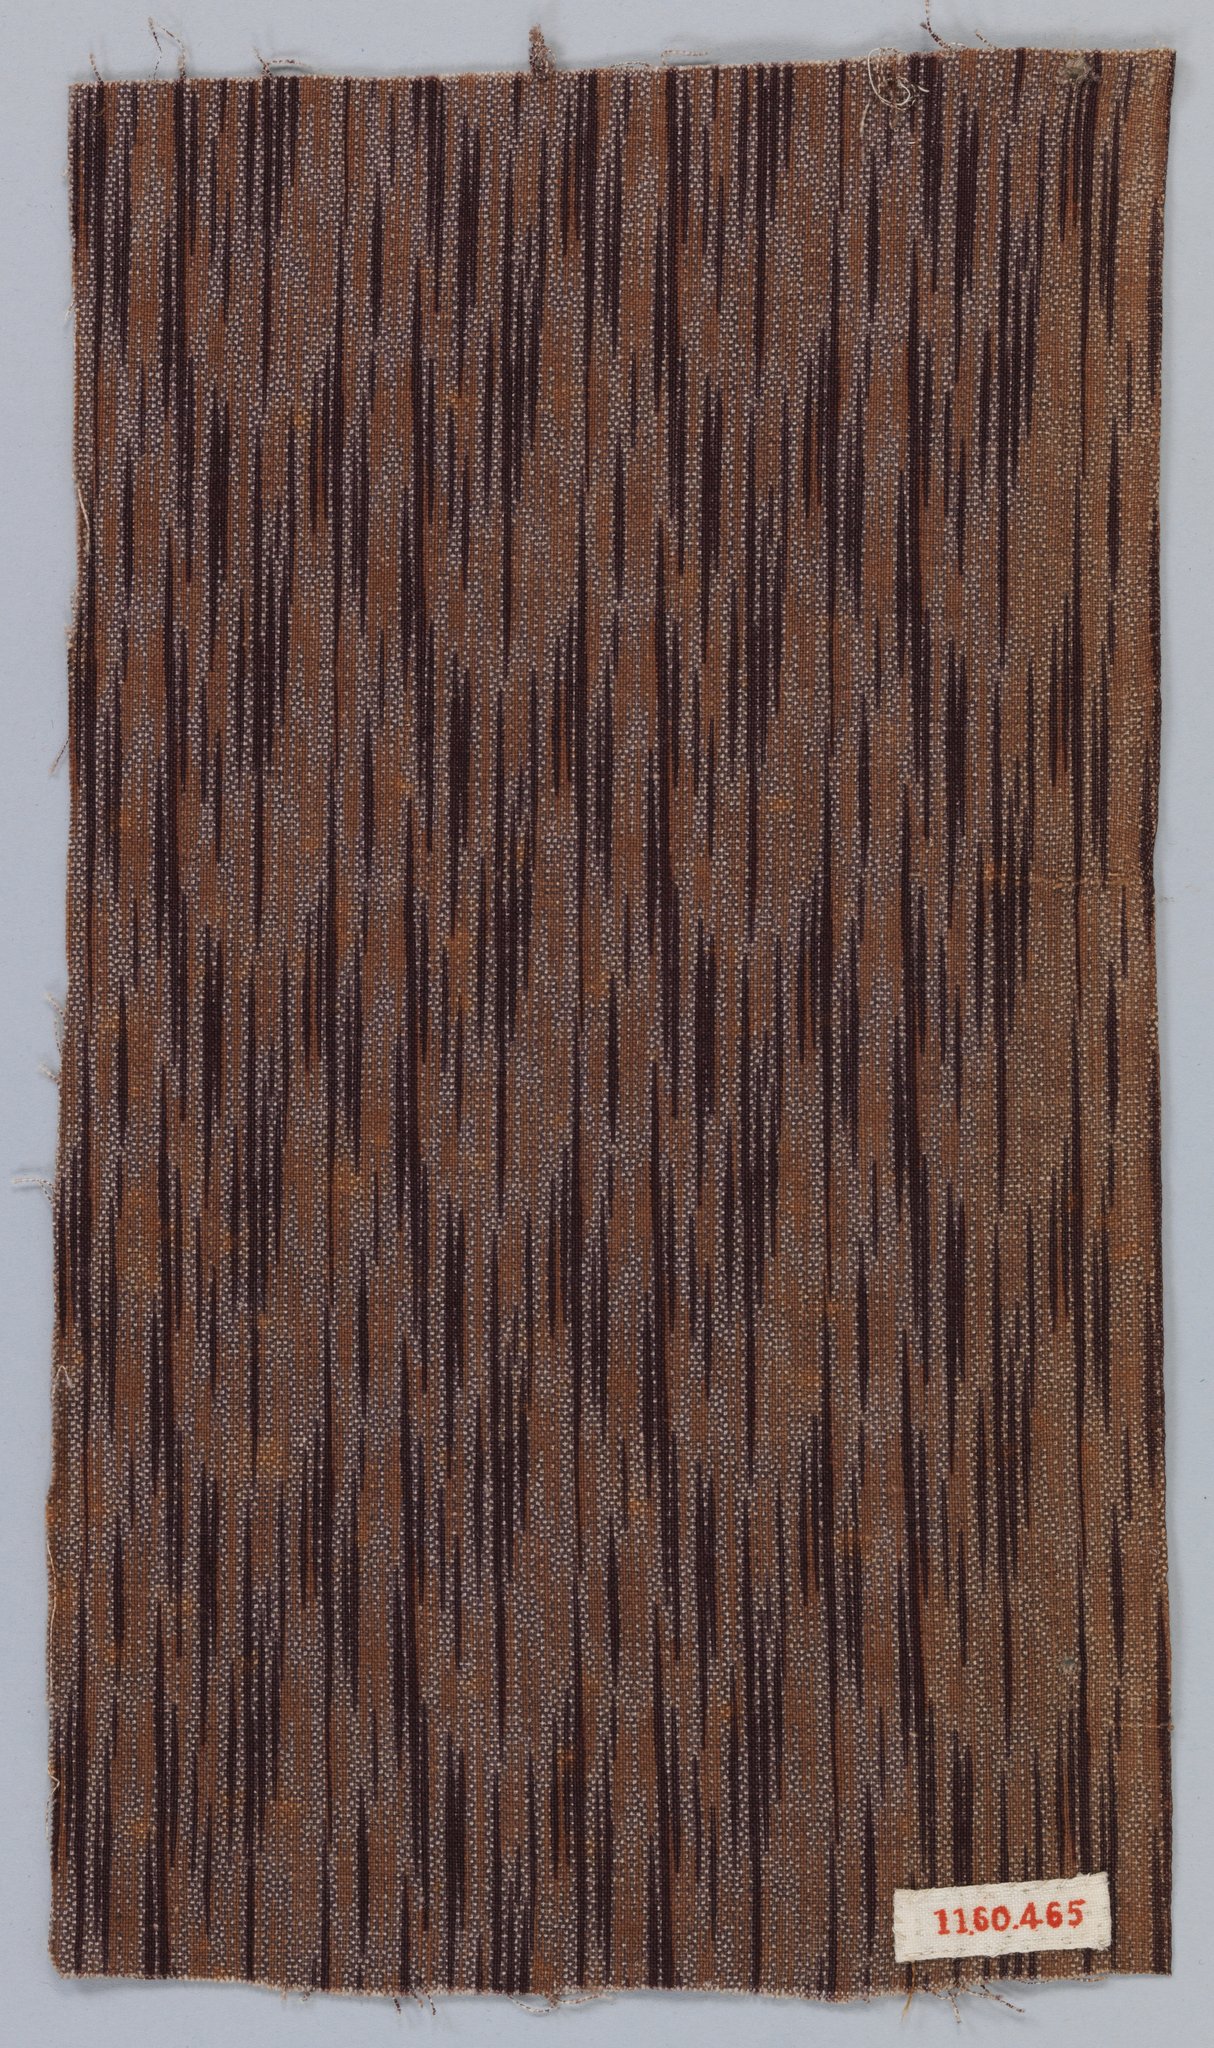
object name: piece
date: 1801-1900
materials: cotton